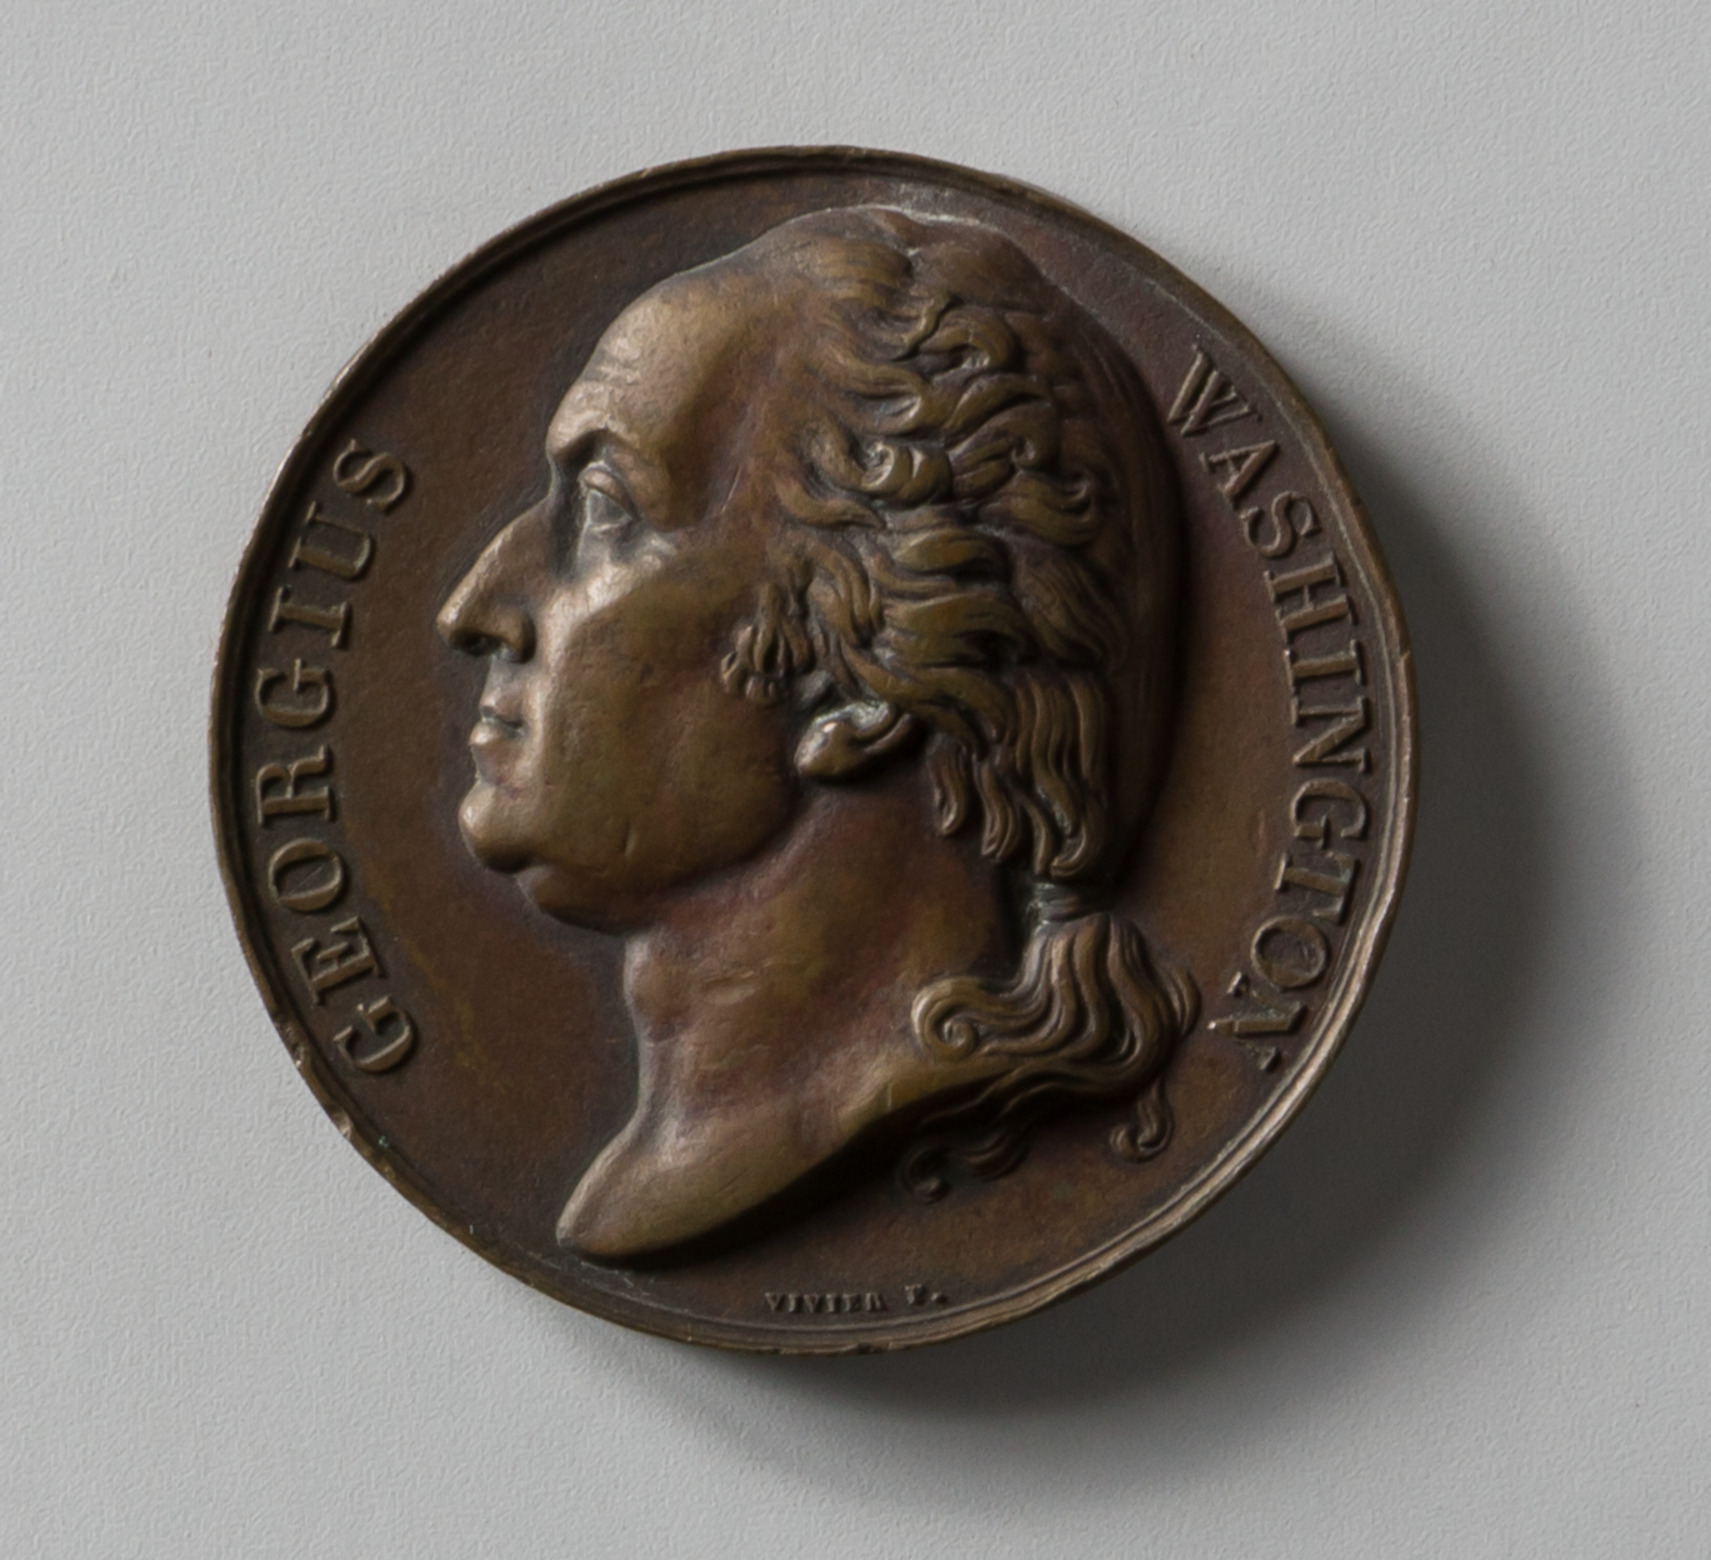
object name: medal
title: George Washington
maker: f. vivier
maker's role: maker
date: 1819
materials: bronze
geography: france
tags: george washington,profiles